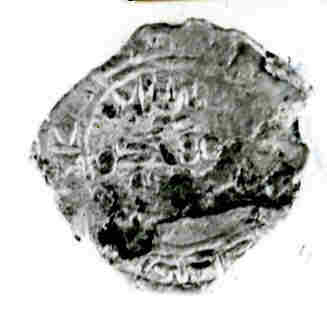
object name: coin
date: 701-800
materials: copper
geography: iran